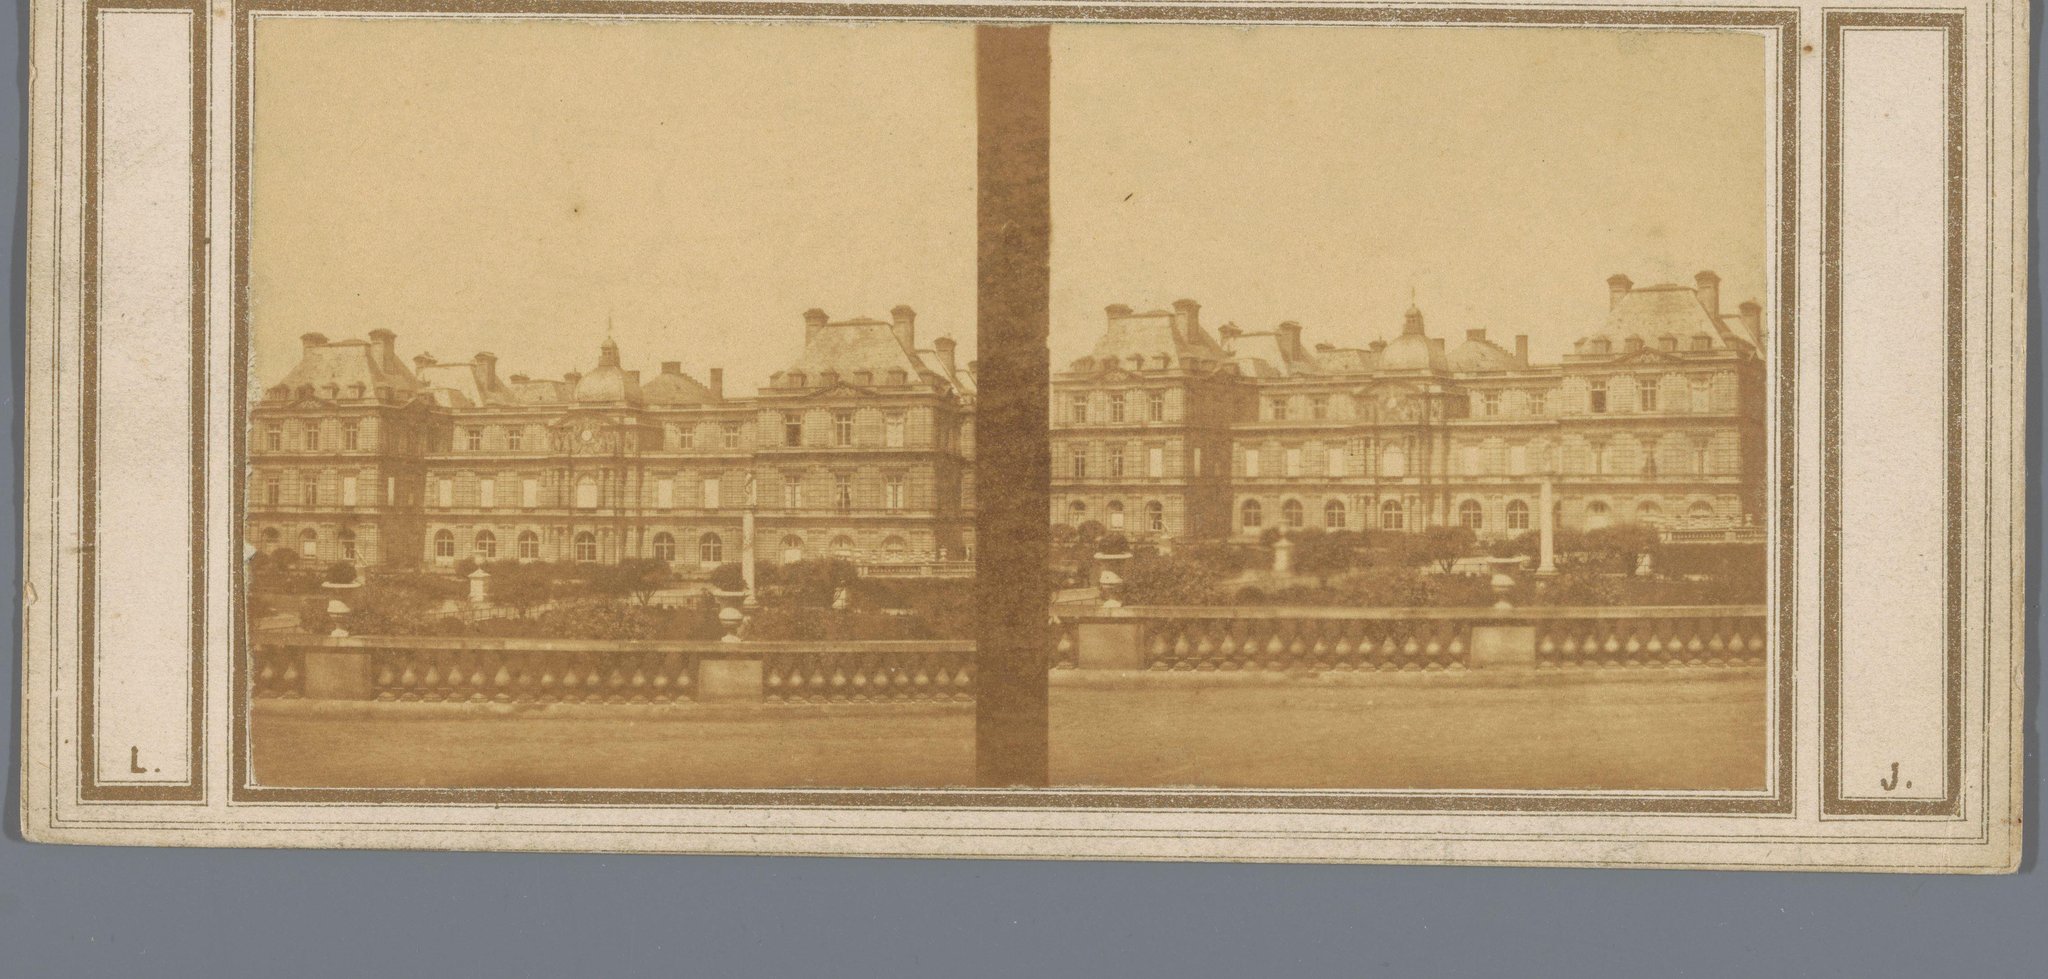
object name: stereograph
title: Gezicht op het Palais du Luxembourg in Parijs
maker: léon pierre jouvin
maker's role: fotograaf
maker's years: 1829-1891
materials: cardboard, photographic support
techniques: salted paper print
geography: paris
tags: palace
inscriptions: inscription: ‘Parijs le Luxembourg’, inscription: ‘zelf gekocht Nov 57.’